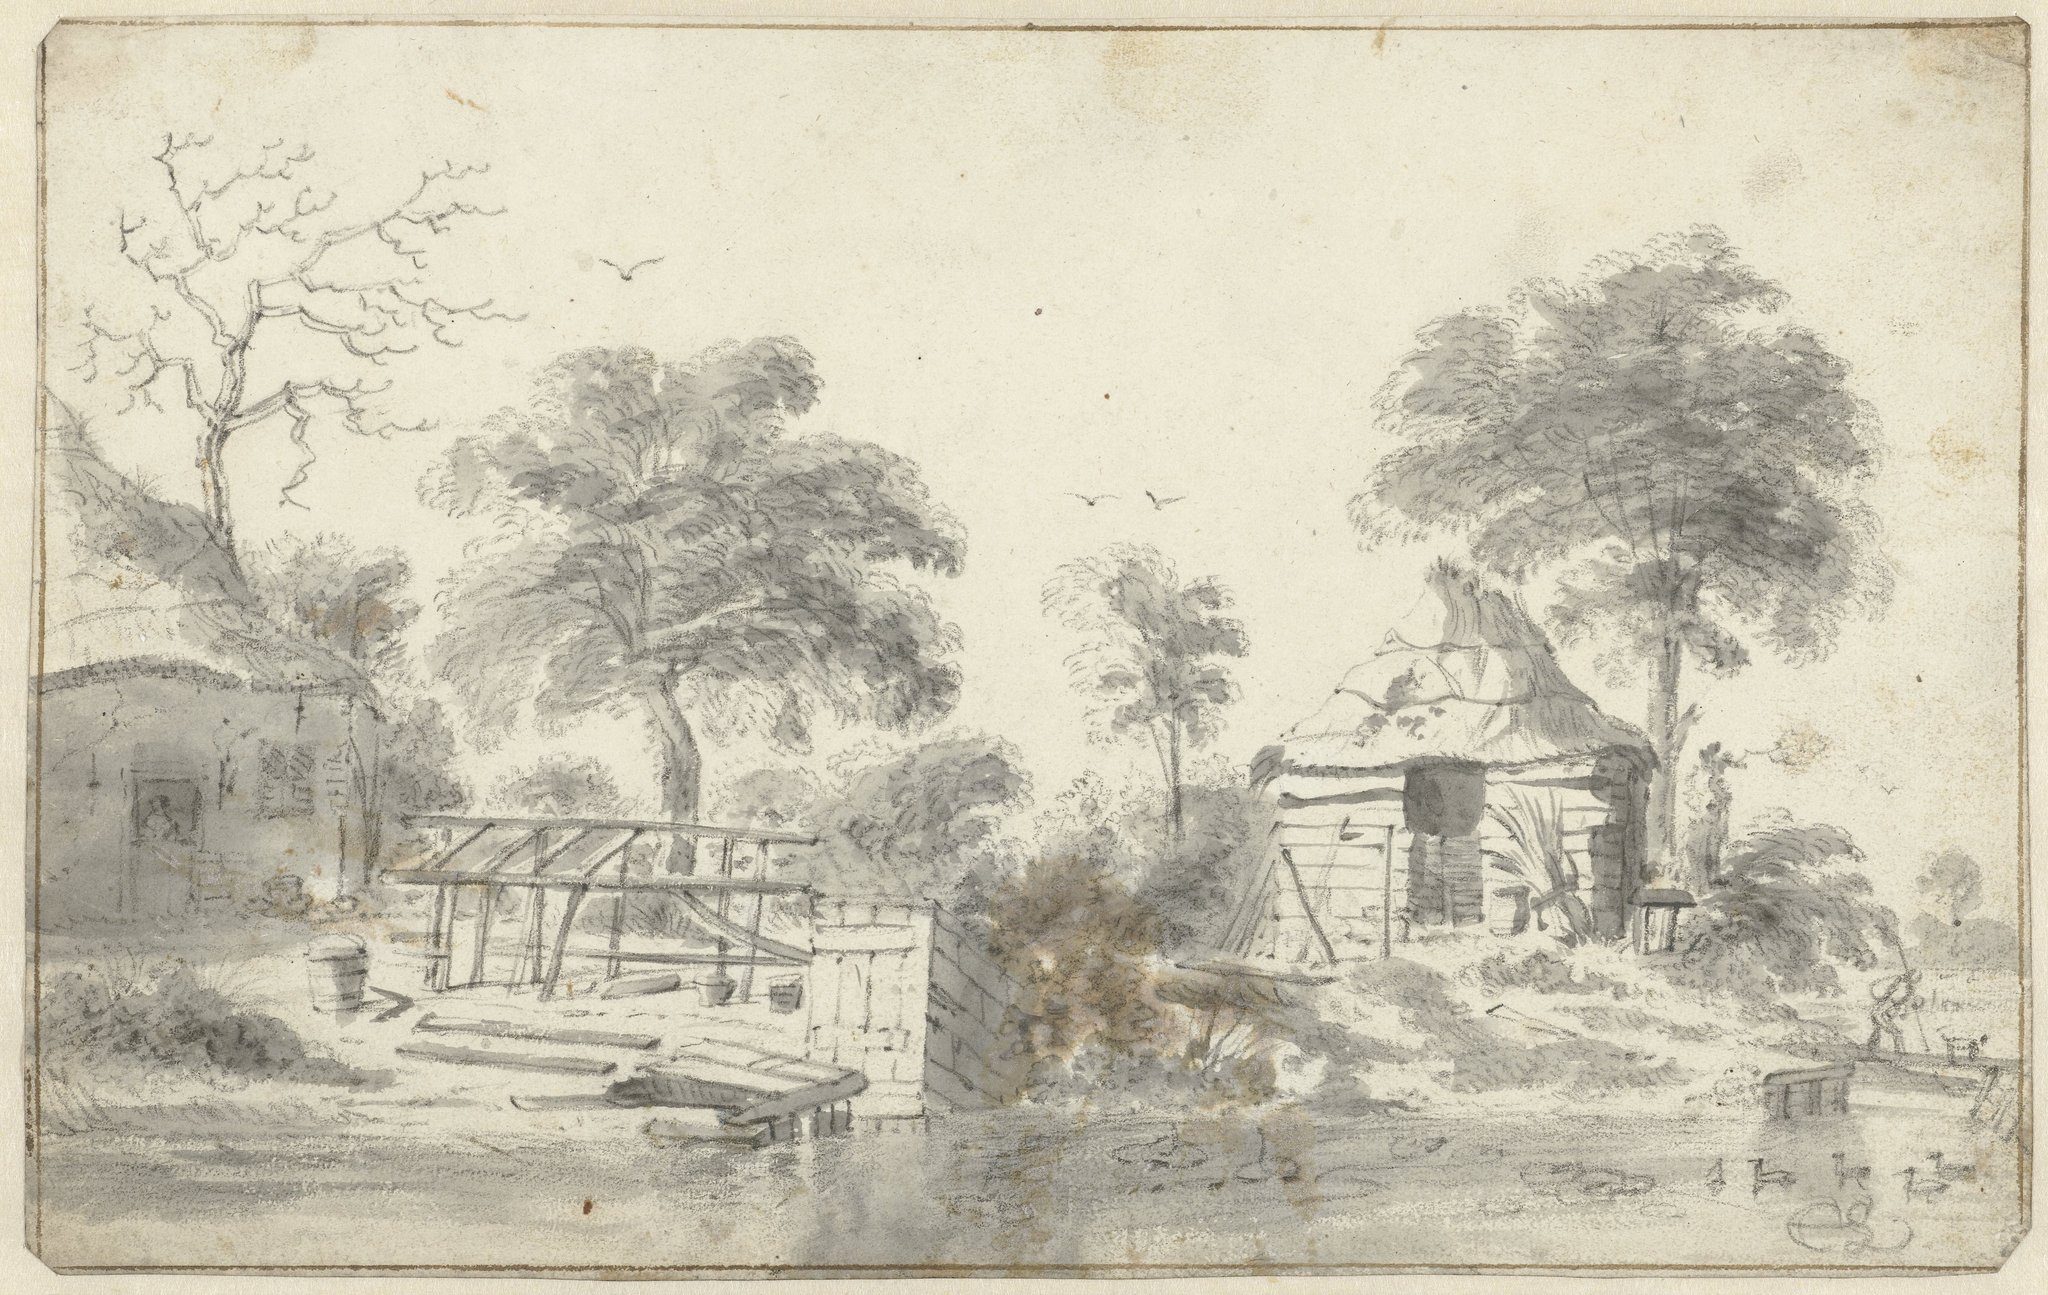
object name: drawing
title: Cottage with a Barn along the Water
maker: cornelis saftleven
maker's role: draughtsman, painter, print maker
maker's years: 1607-1681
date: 1617-1681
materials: chalk, ink, paper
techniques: brush, drawing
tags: landscapes with waters, waterscapes, seascapes (in the temperate zone), farm (building)